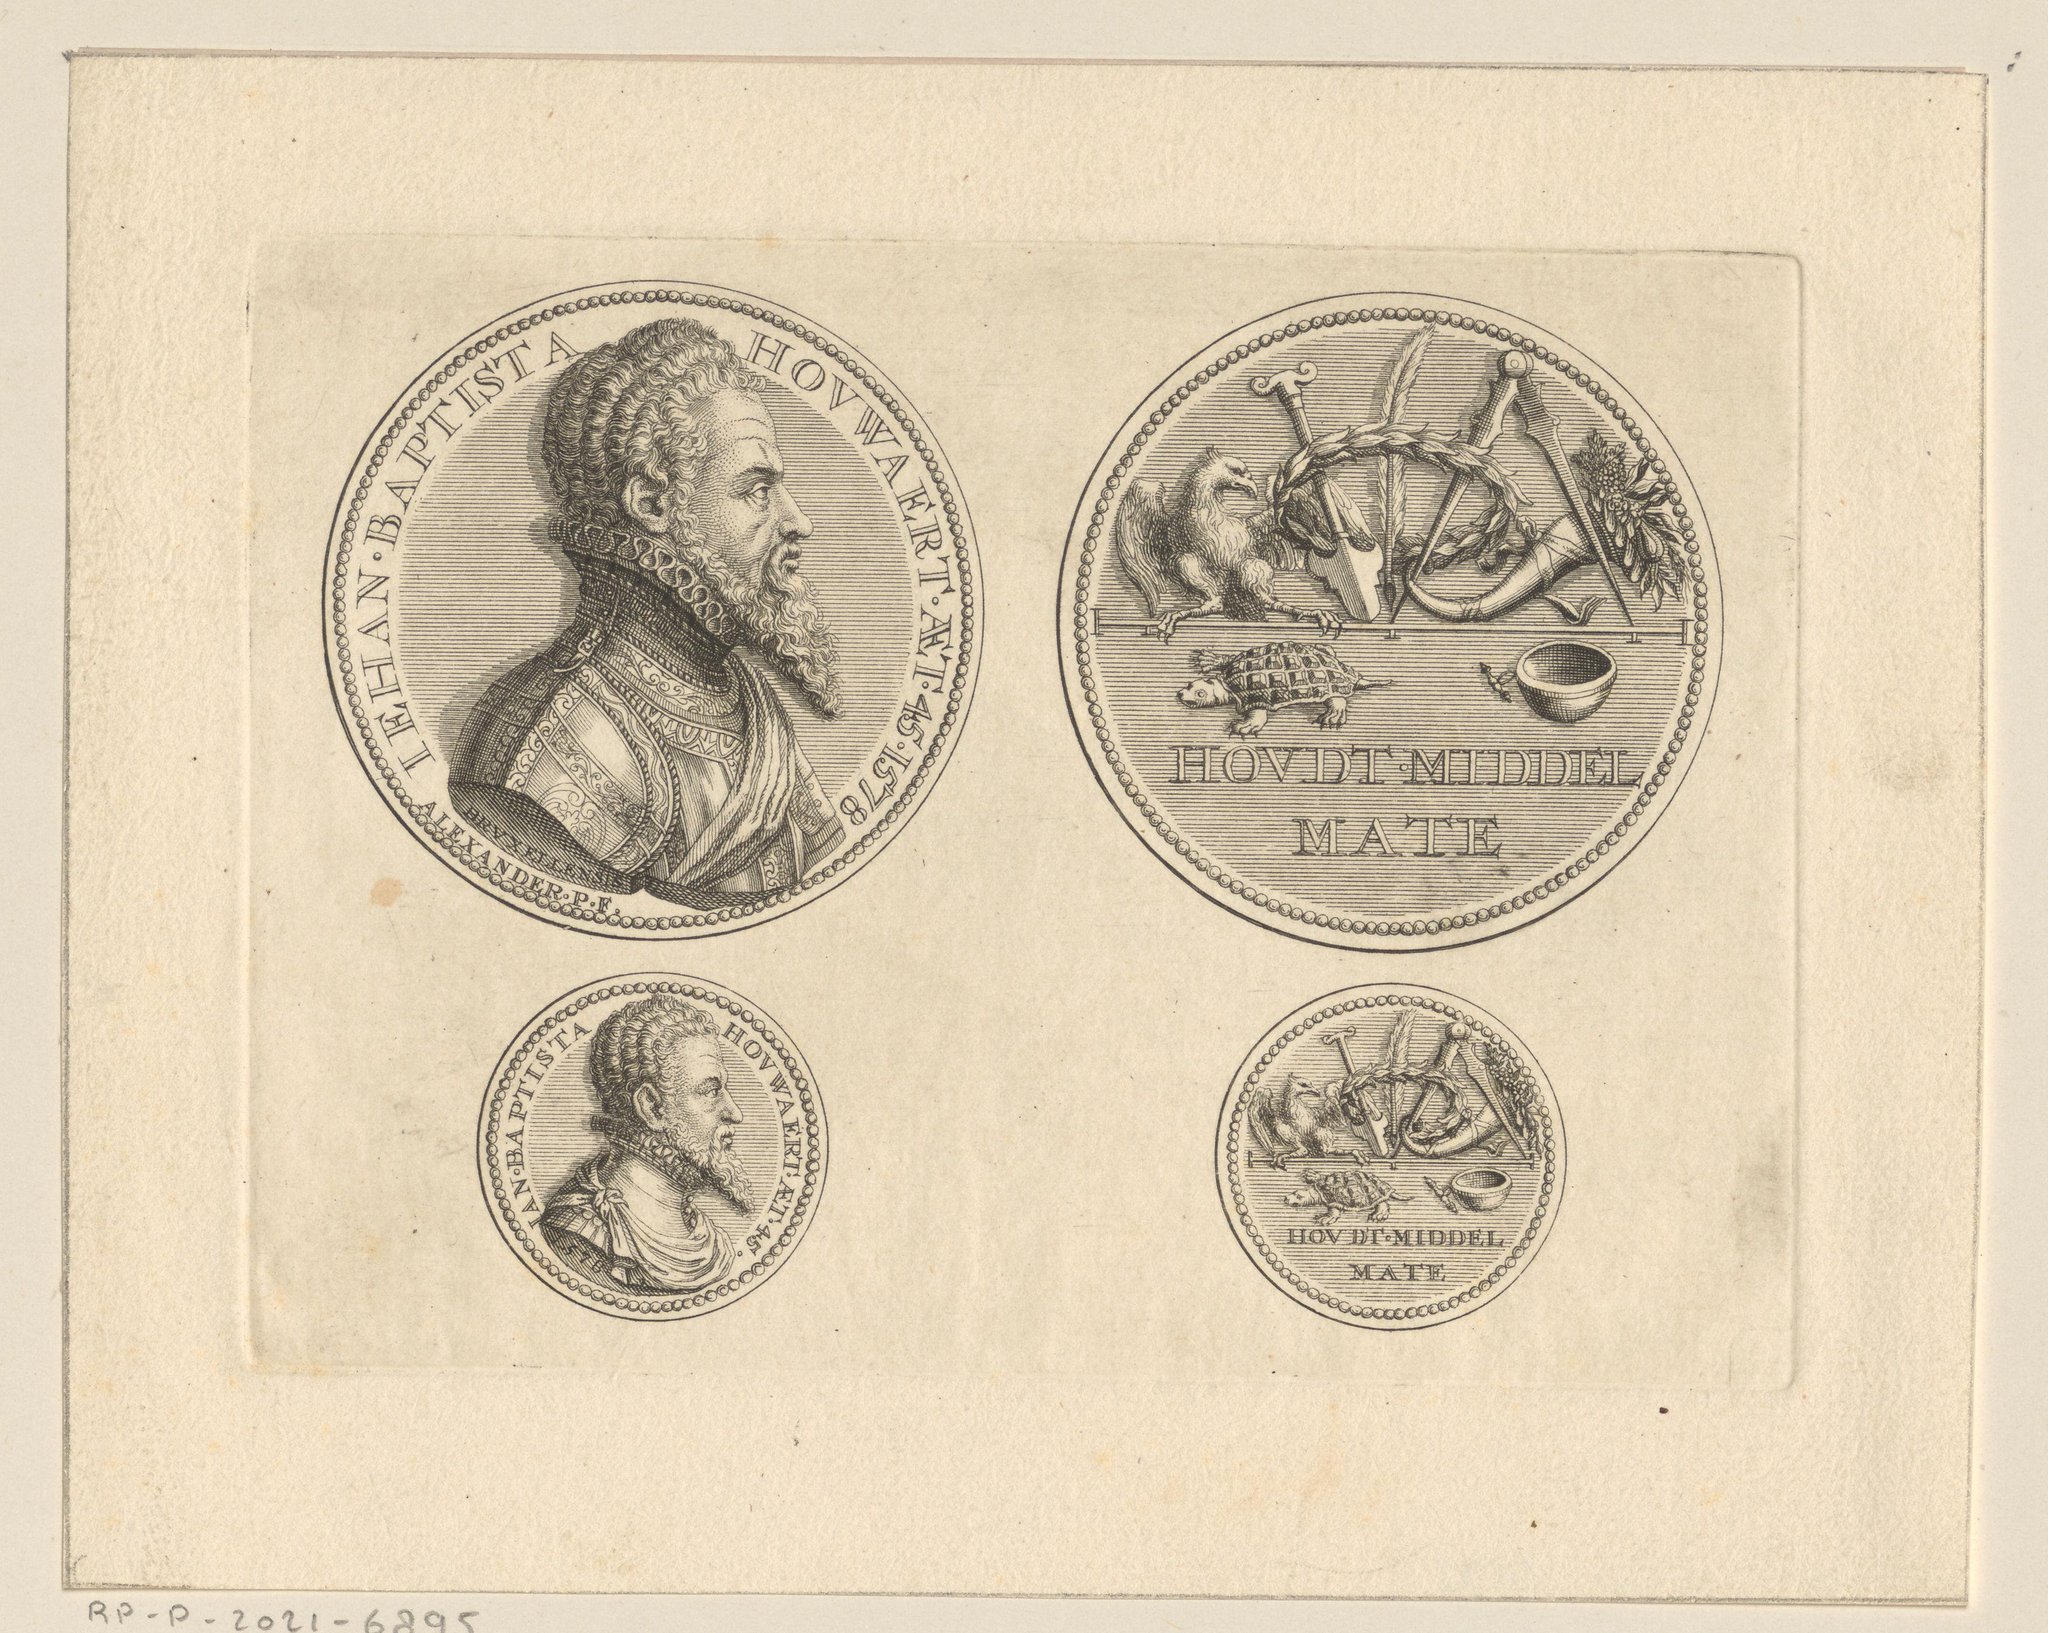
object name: print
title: Penningen met portret van Jan Baptist Houwaert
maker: Anonymous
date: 1723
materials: paper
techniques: etching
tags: historical persons, medal (considered as a piece of sculpture, regardless of its specific function)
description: Latere staat van de prent met tekst op verso gebruikt in: Loon, Gerard van. Beschryving der Nederlandsche historipenningen (...). Den Haag: Christiaan van Lom, Isaac Vaillant, Pierre Gosse, Rutgert Christoffel Alberts en Pieter de Hondt, 1723, dl. 1, p. 245.